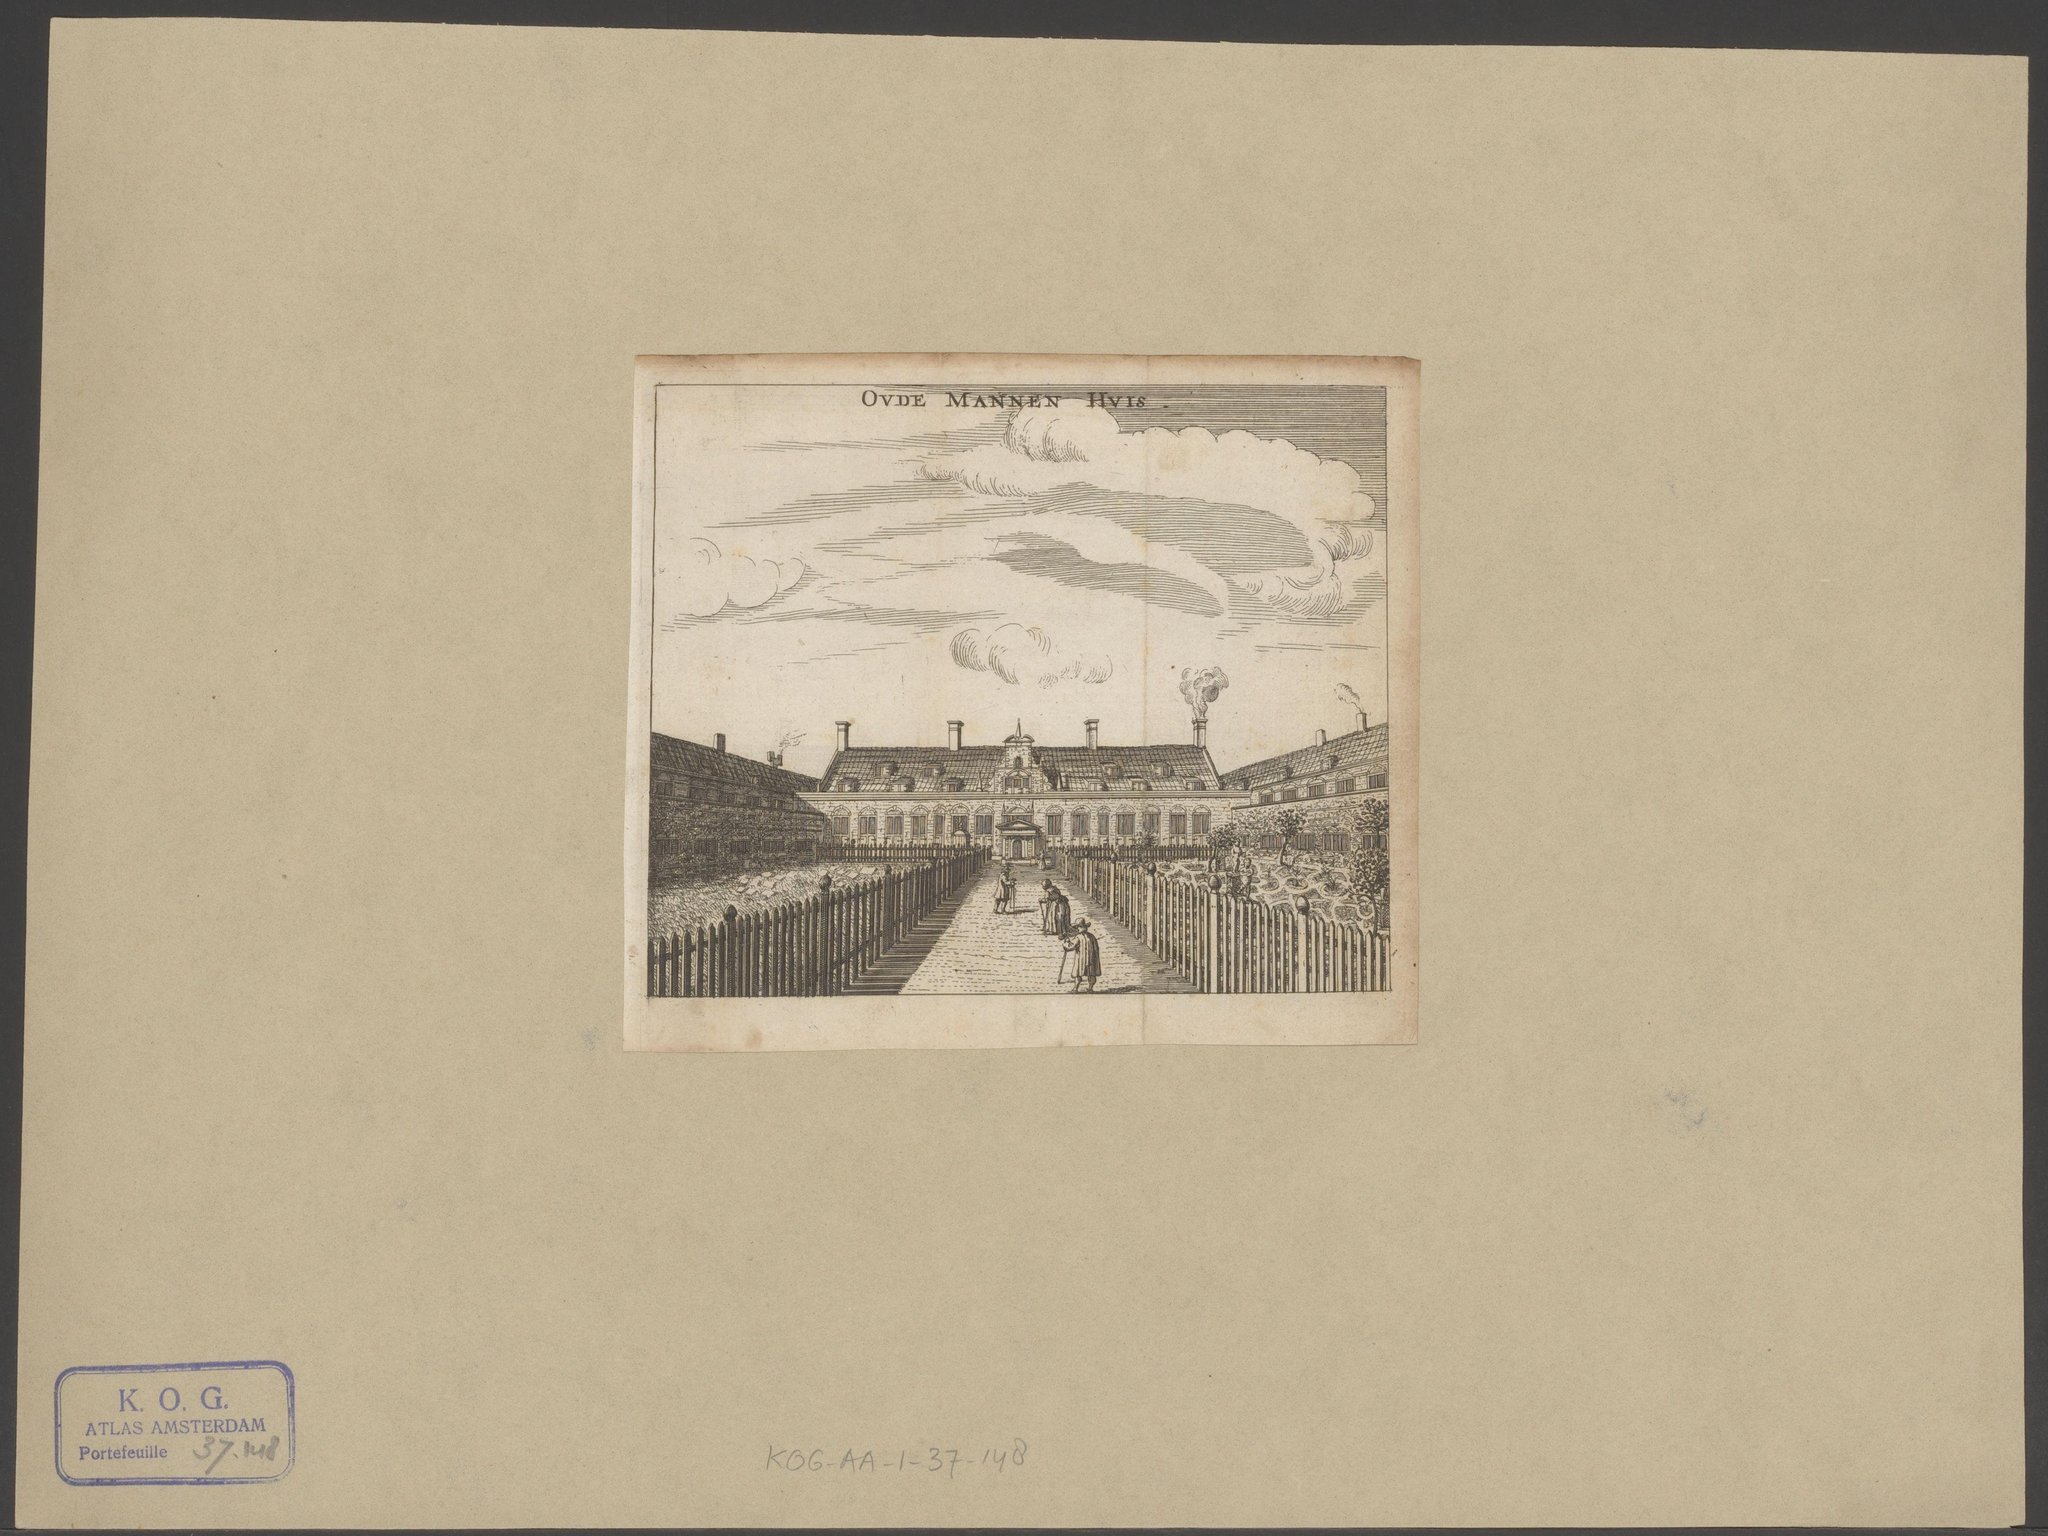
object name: print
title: Gezicht op de binnenplaats van het Oudemannenhuis te Amsterdam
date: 1664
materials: paper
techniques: engraving, etching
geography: amsterdam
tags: courtyard, old-people's home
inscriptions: collector's mark: Lugt 1641b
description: Huidige staat van prent ook gebruikt in: Fockens, Melchior. Beschrijvingh Der wijdt-vermaarde Koop-stadt Amstelredam (…). 3de druk. Amsterdam: Marcus Willemsz. Doornick, 1664. En in: Zesen, Philipp von. Beschreibung der Stadt Amsterdam (…). Amsterdam: Marcus Wilhelm Doornick, 1664. Tweede bekende staat (met toevoeging Franse titel) ook gebruikt in: Domselaer, Tobias en Isaac Commelin. Beschryvinge van Amsterdam (…). 6 dln. Amsterdam: Marcus Willemsz. Doornick, 1665, dl. 4, p. 145. Derde bekende staat (rechtsboven genummerd: 27) ook gebruikt in verschillende latere zeventiende- en achttiende-eeuwse publicaties.